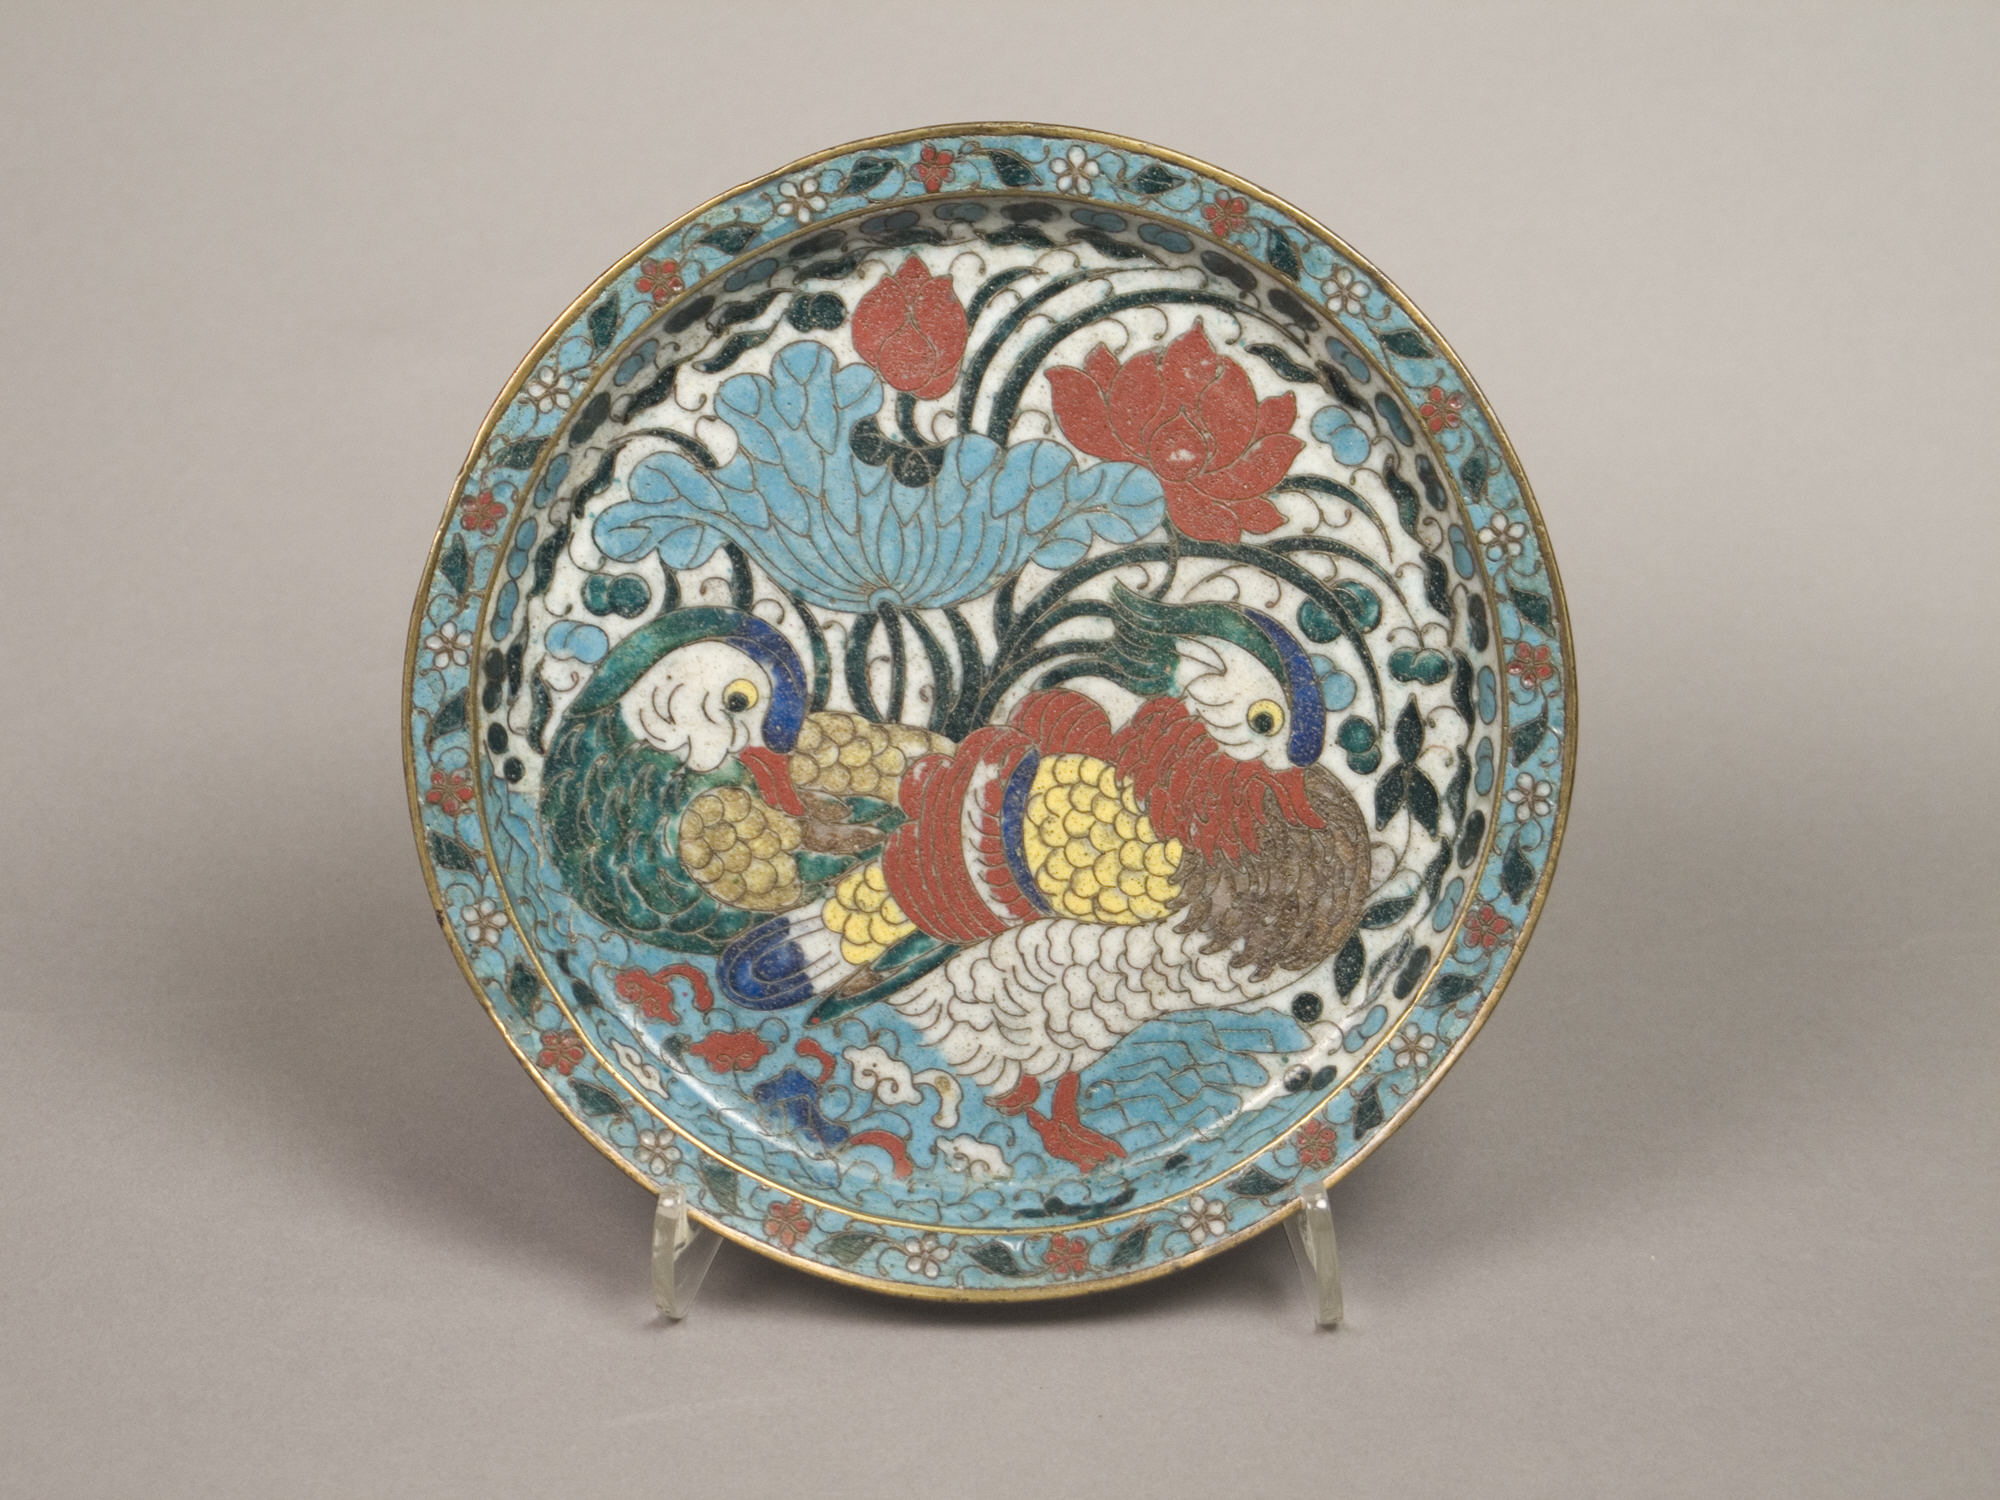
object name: dish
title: Dish with mandarin ducks and lotuses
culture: chinese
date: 1467-1533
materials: enamel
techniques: enamel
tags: ducks,lotuses